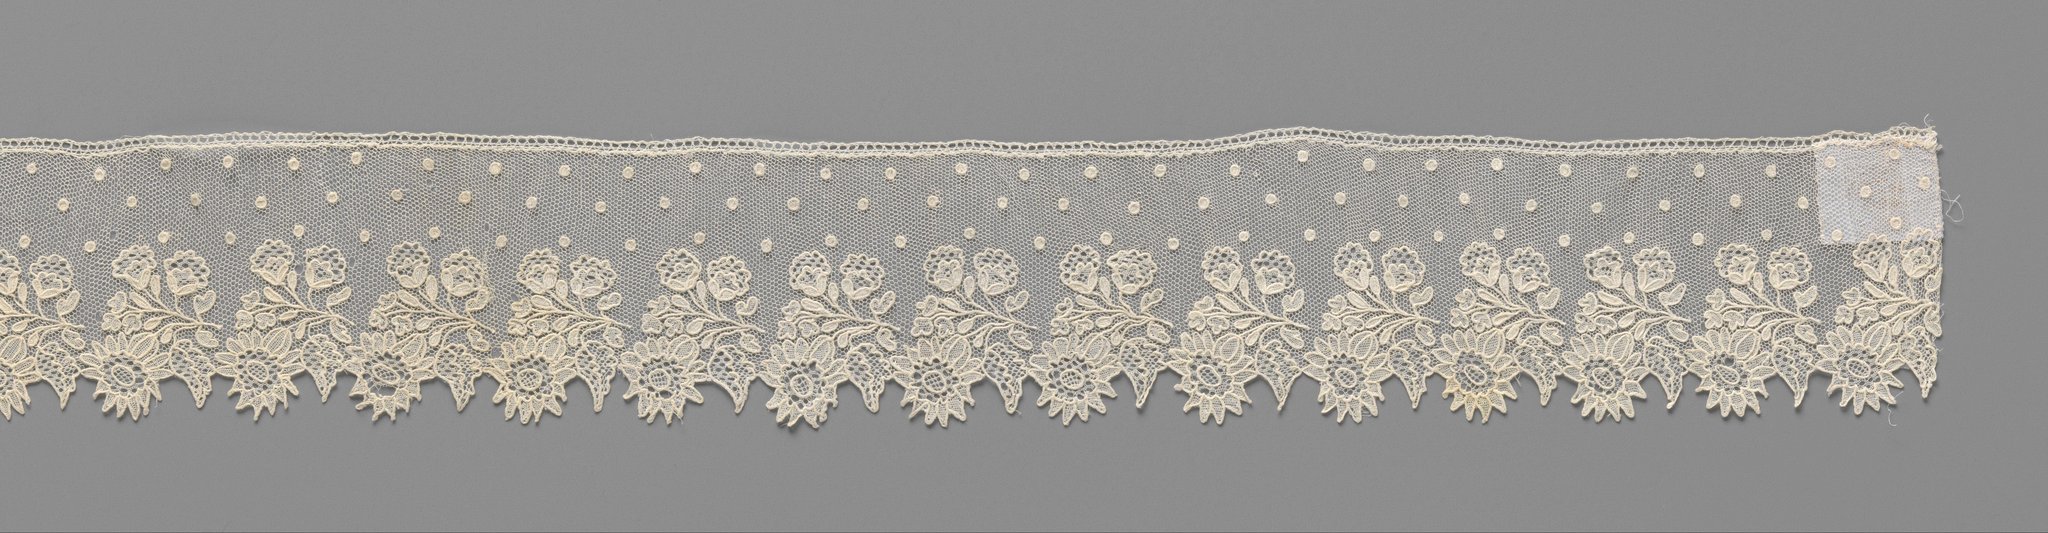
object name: strip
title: Strook naaldkant met liggende tak met drie bloemen onder moesjes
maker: Anonymous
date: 1825-1835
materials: linen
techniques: lace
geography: alençon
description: Strook naturelkleurige naaldkant: Alençon-kant. Onder een strooipatroon van drie rijen moesjes bestaat het zich herhalende patroon uit een liggende bloemtak. De opeenvolgende takken zijn naar links gericht en hebben elk drie bloemen, enkele kleine blaadjes en één groter druppelvormig blad. De grootste van de drie bloemen vormen afwisselend met het druppelvormige blad de schulpenrand langs de onderzijde van de strook. De twee kleinere bloemen zitten aan de andere kant van de tak en steken tussen de moesjes in de onderste rij. De motieven zijn opgebouwd uit festonsteken en worden geaccentueerd door reliëfcontouren. In de bloemen en in het druppelvormige blad zijn siergrondjes toegepast. De motieven worden met elkaar verbonden door een fijne maasgrond, een Alençon-grond. De bovenzijde van de strook is recht afgewerkt met een geklost bandje.